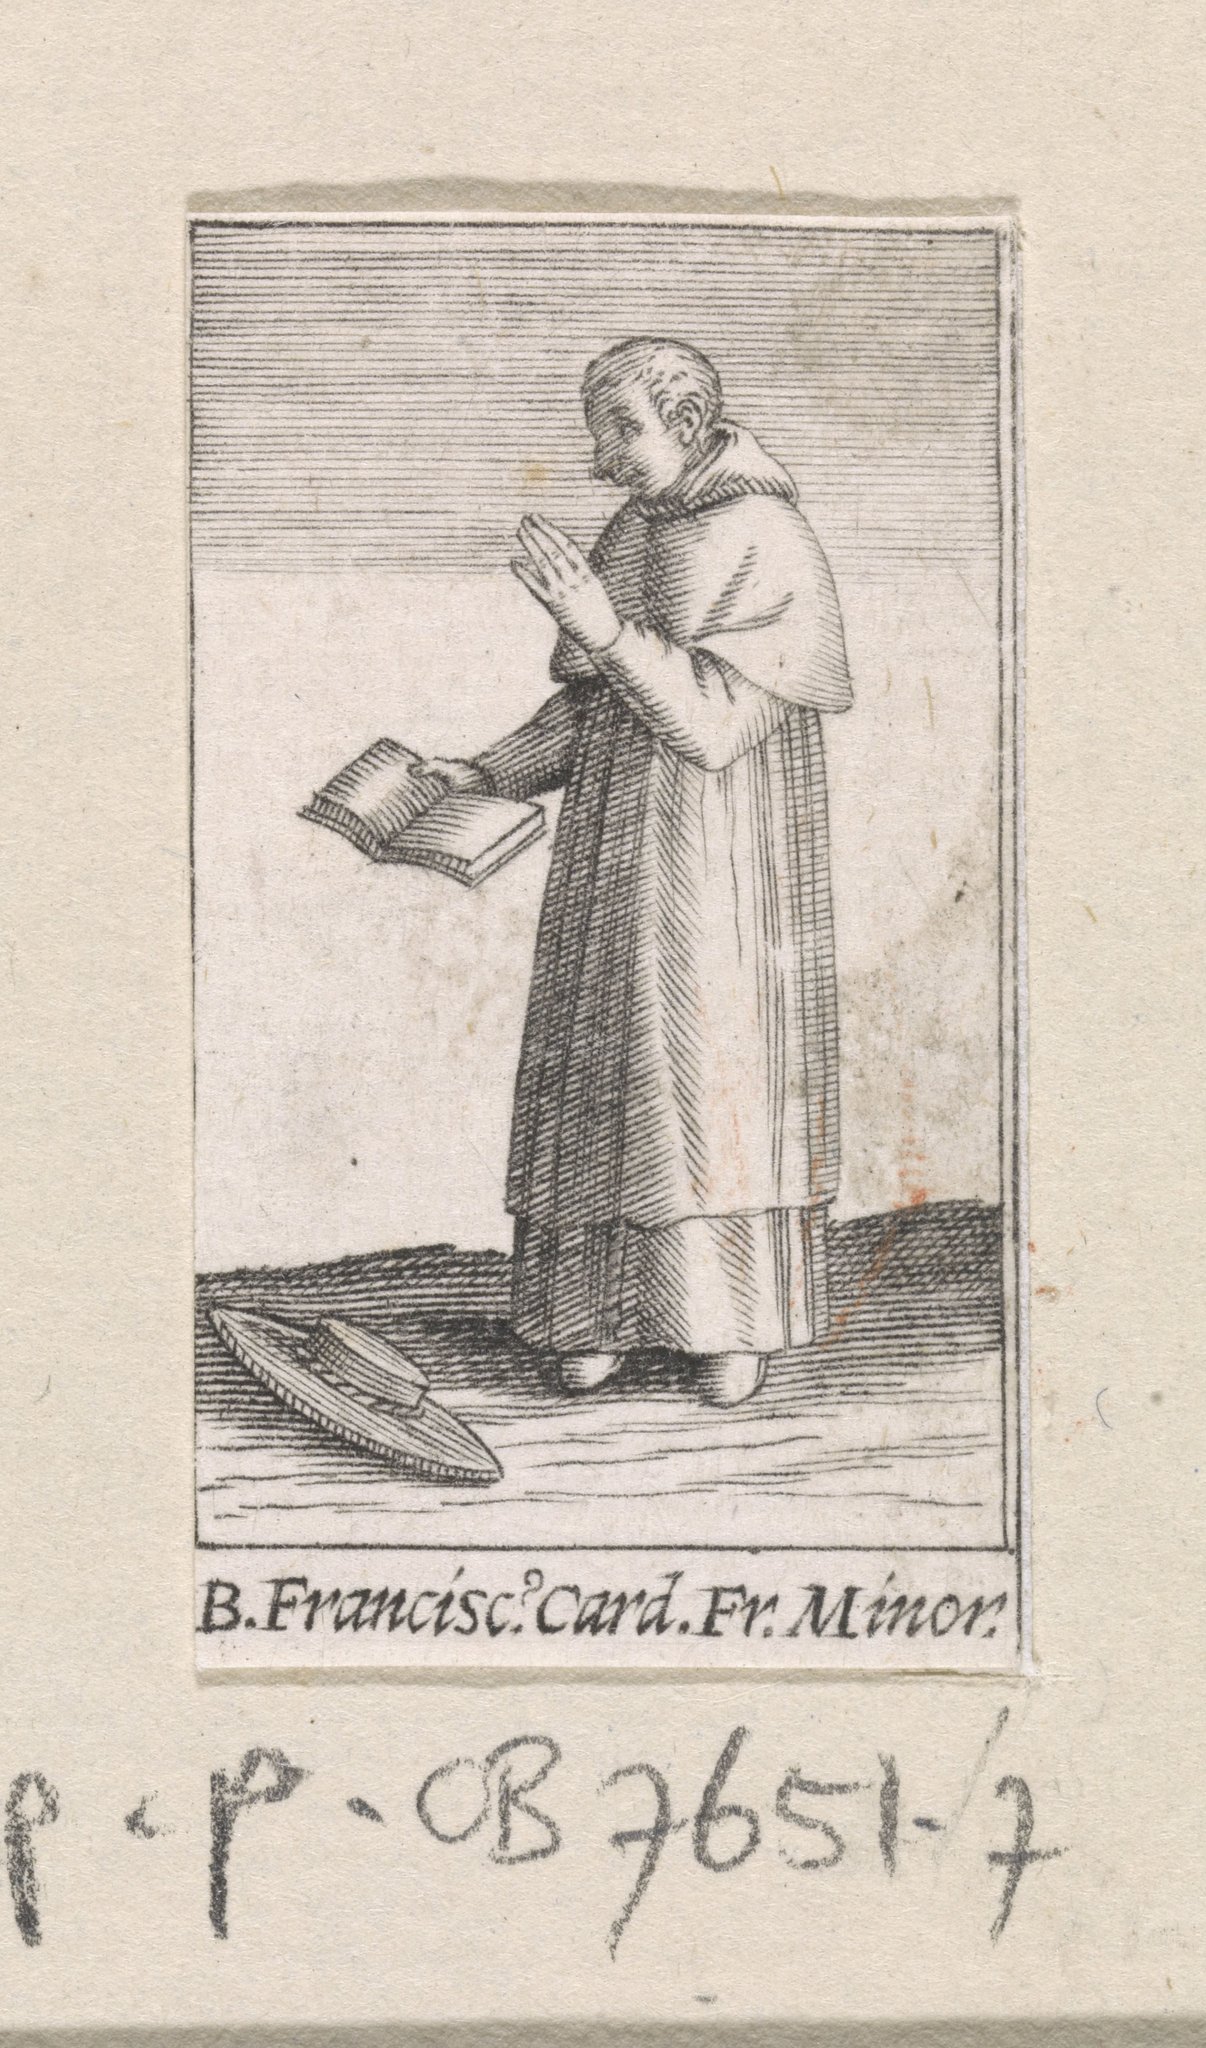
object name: print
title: Portret van een onbekende franciscaner monnik, genaamd Franciscus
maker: Anonymous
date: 1570-1632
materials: paper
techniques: engraving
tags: monastic orders, monastic life: franciscans, insignia of cardinal, e.g. hat, mantle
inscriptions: collector's mark: Lugt 240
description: Een franciscaner monnik genaamd Franciscus, een boek in zijn handen. Op de grond een kardinaalshoed.